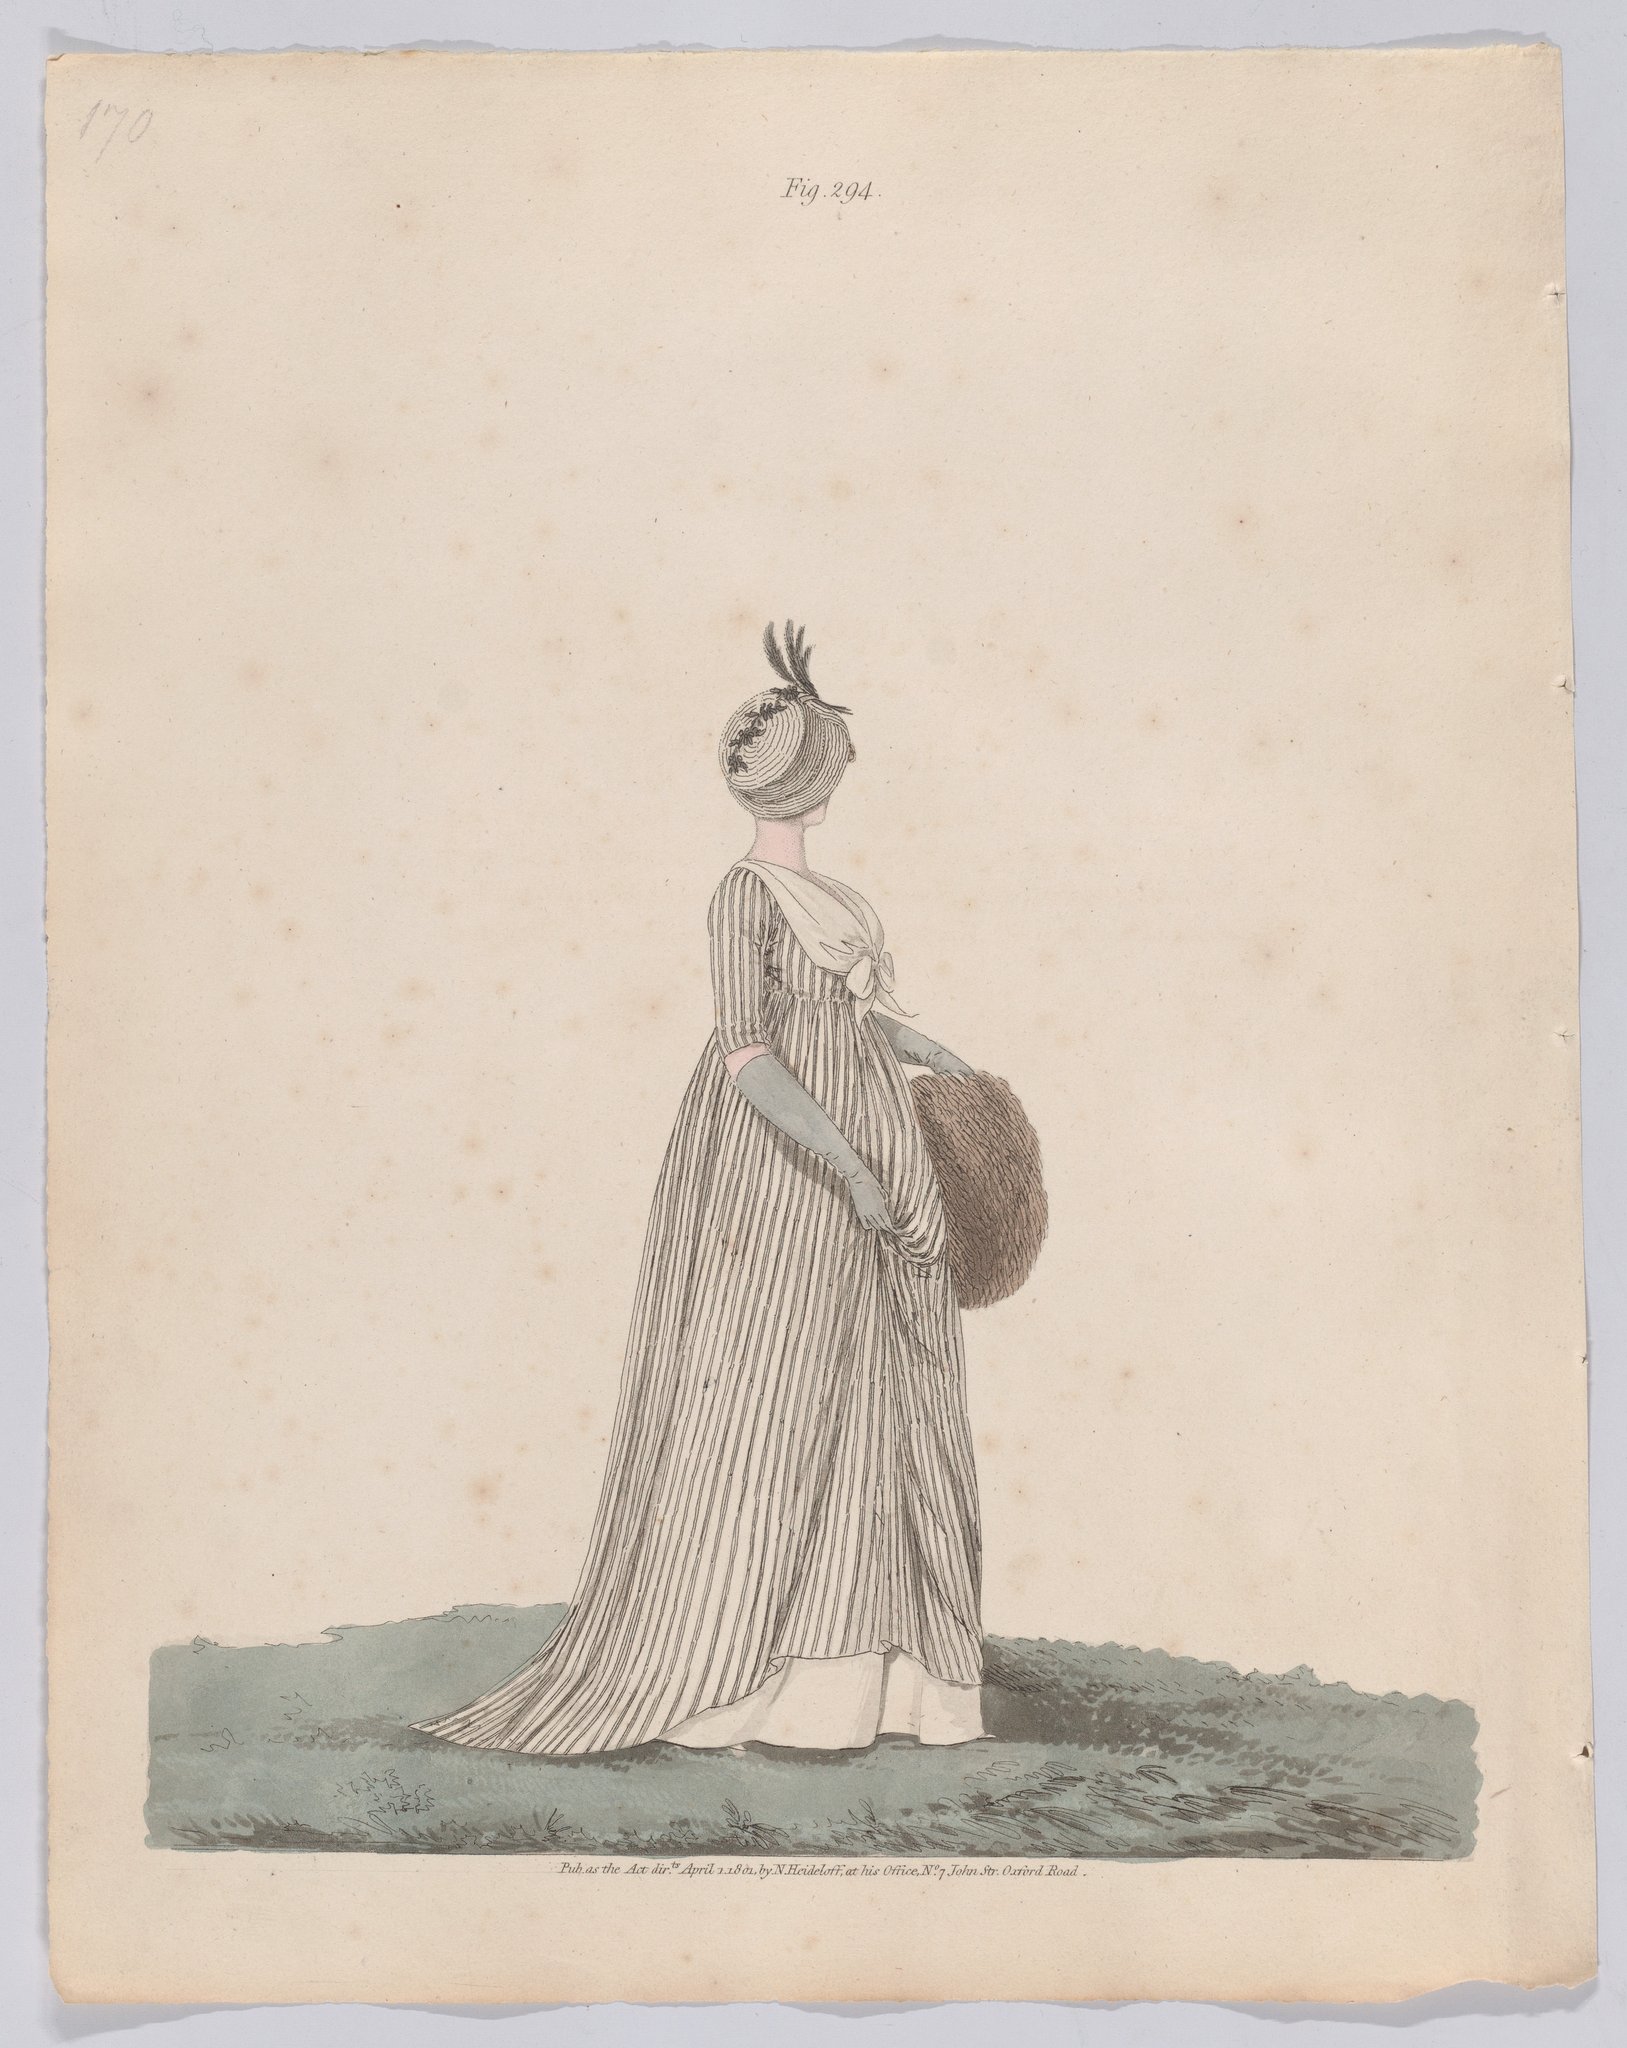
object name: book costume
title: Gallery of Fashion, vol. VIII (April 1, 1801 - March 1 1802)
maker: nicolaus heideloff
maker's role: publisher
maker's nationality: british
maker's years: 1761-1837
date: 1794-1802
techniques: engraving, etching, hand coloring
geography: england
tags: women,fashion